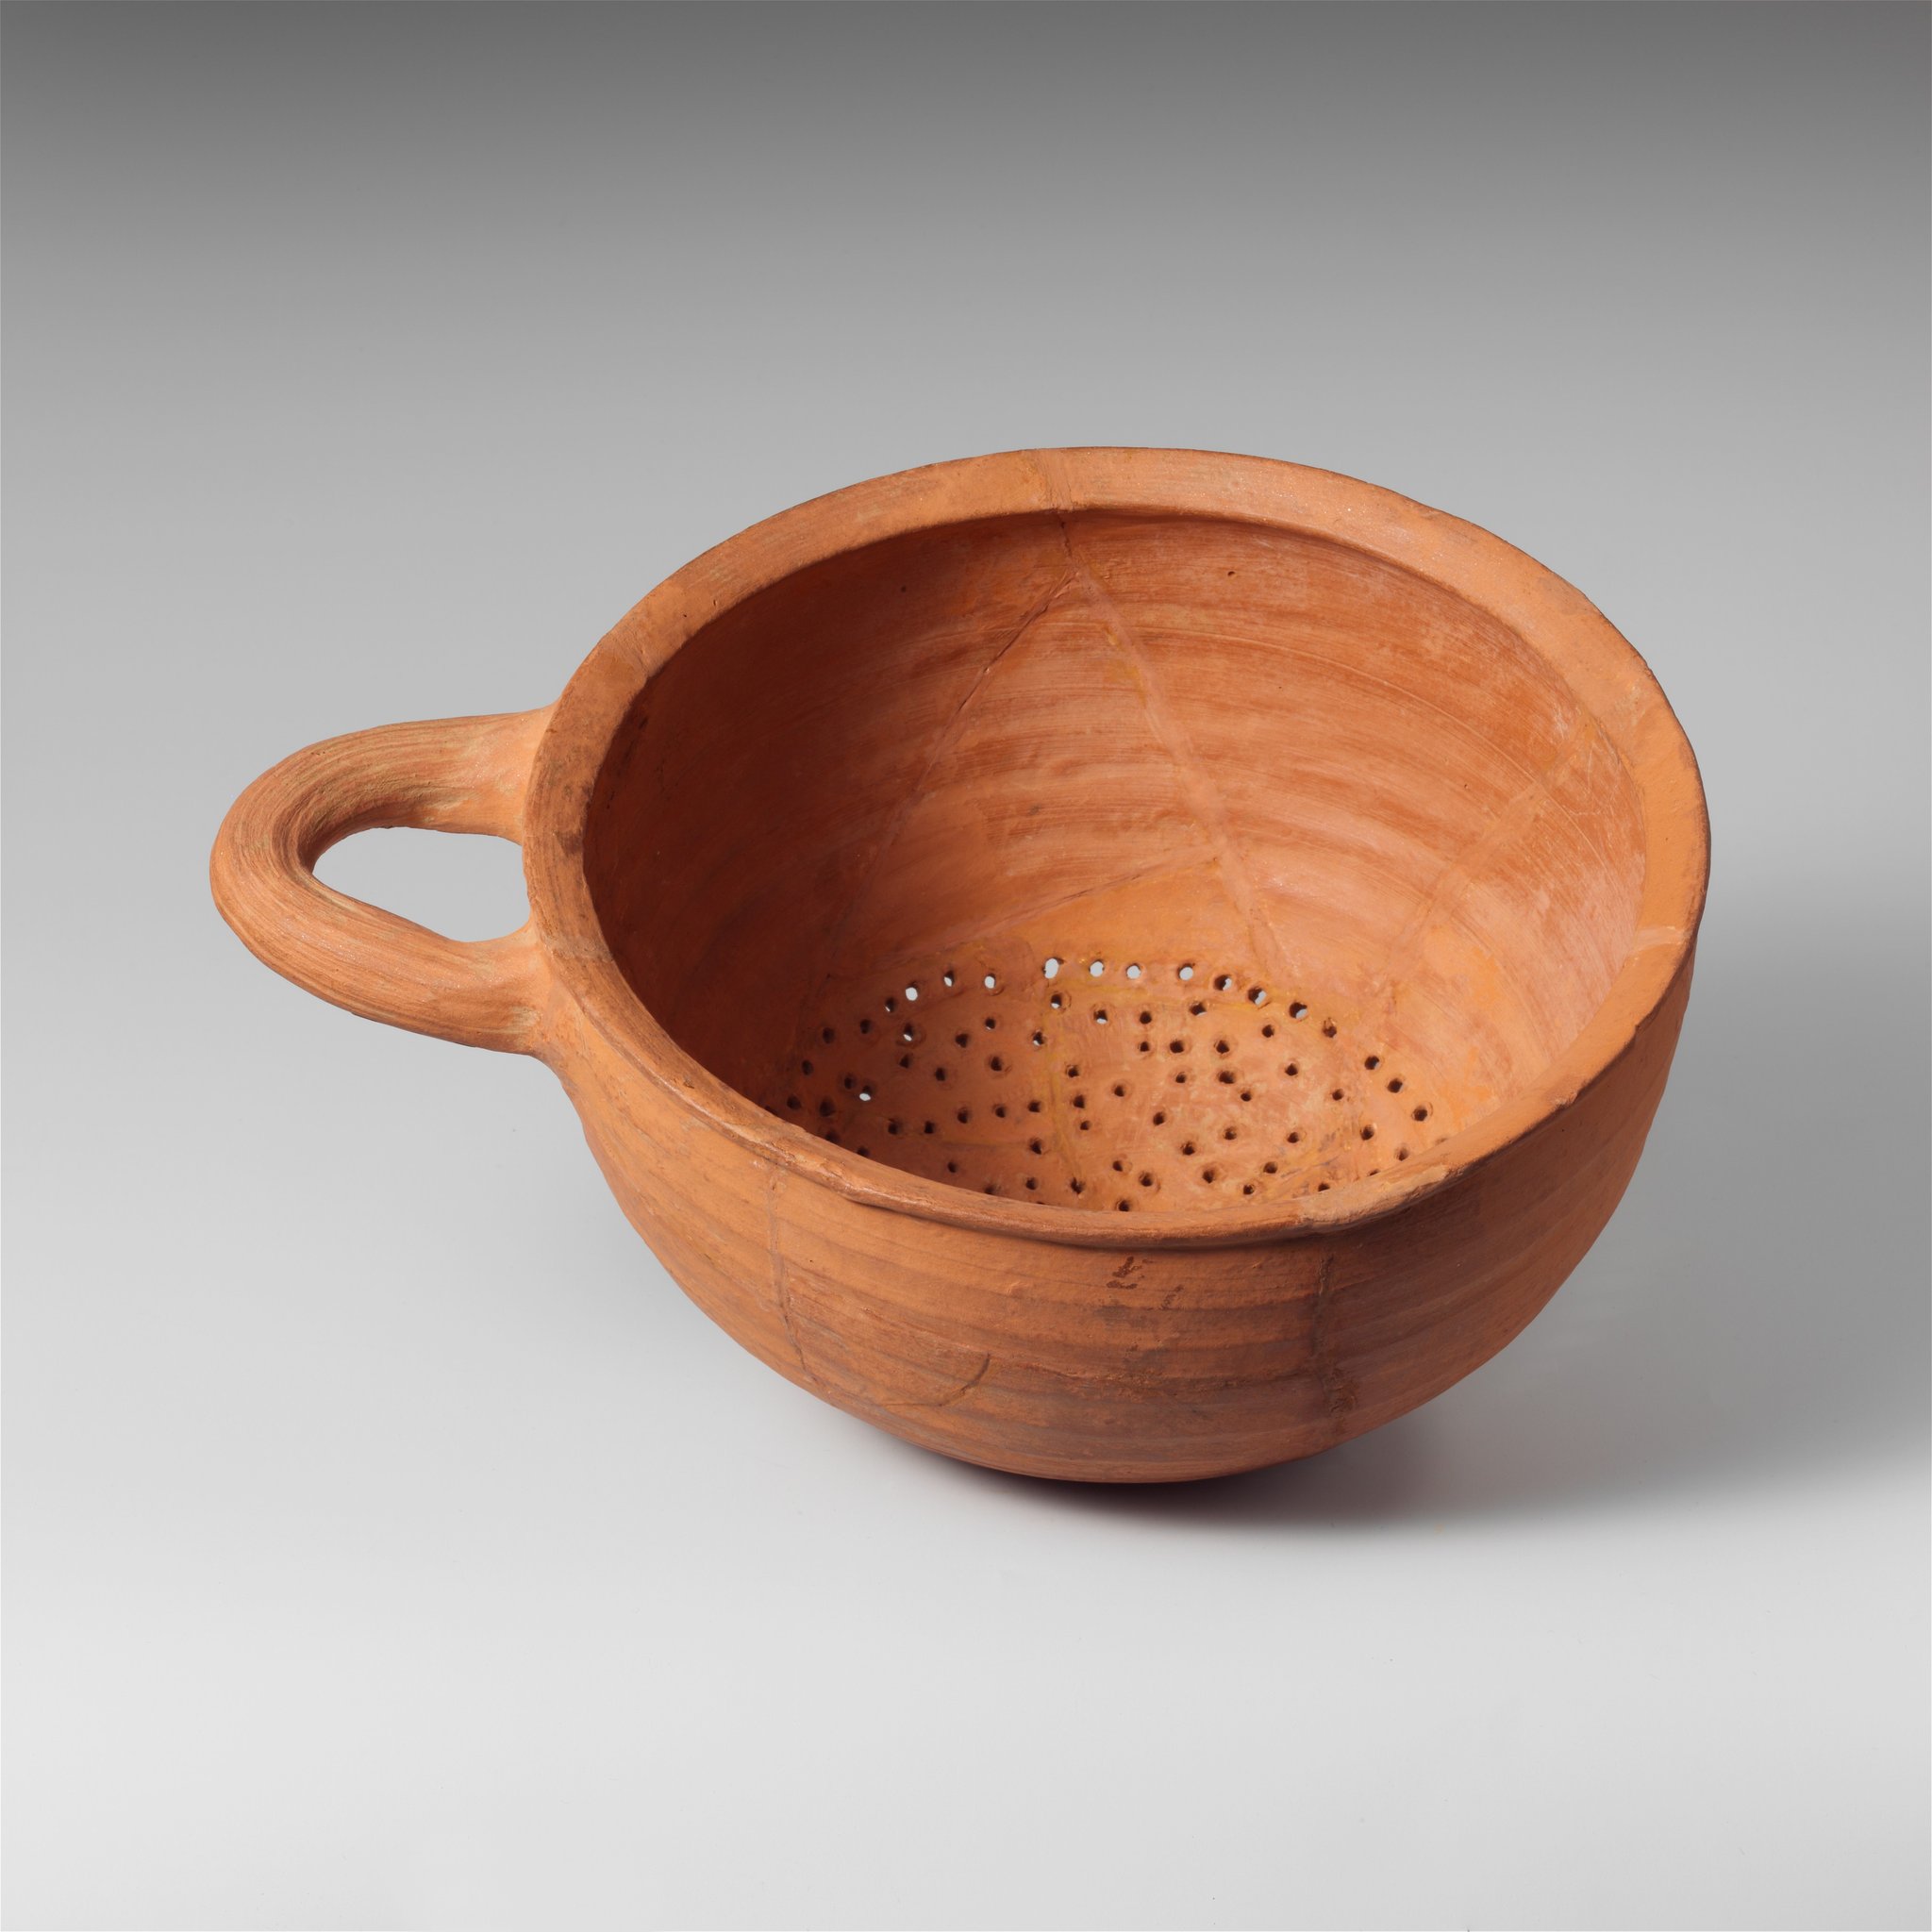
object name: strainer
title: Terracotta hemispherical strainer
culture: lydian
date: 600-501 BCE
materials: terracotta